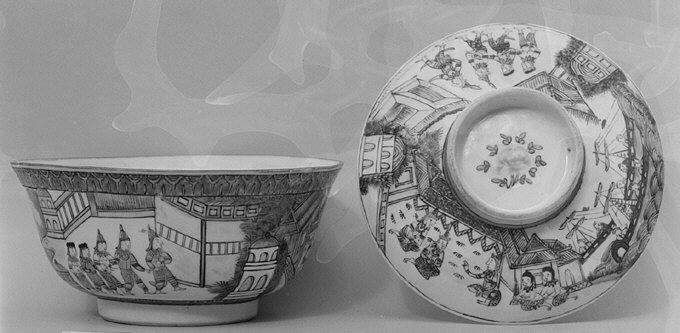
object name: bowl with cover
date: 1801-1900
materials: hard paste porcelain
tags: houses,men,ships